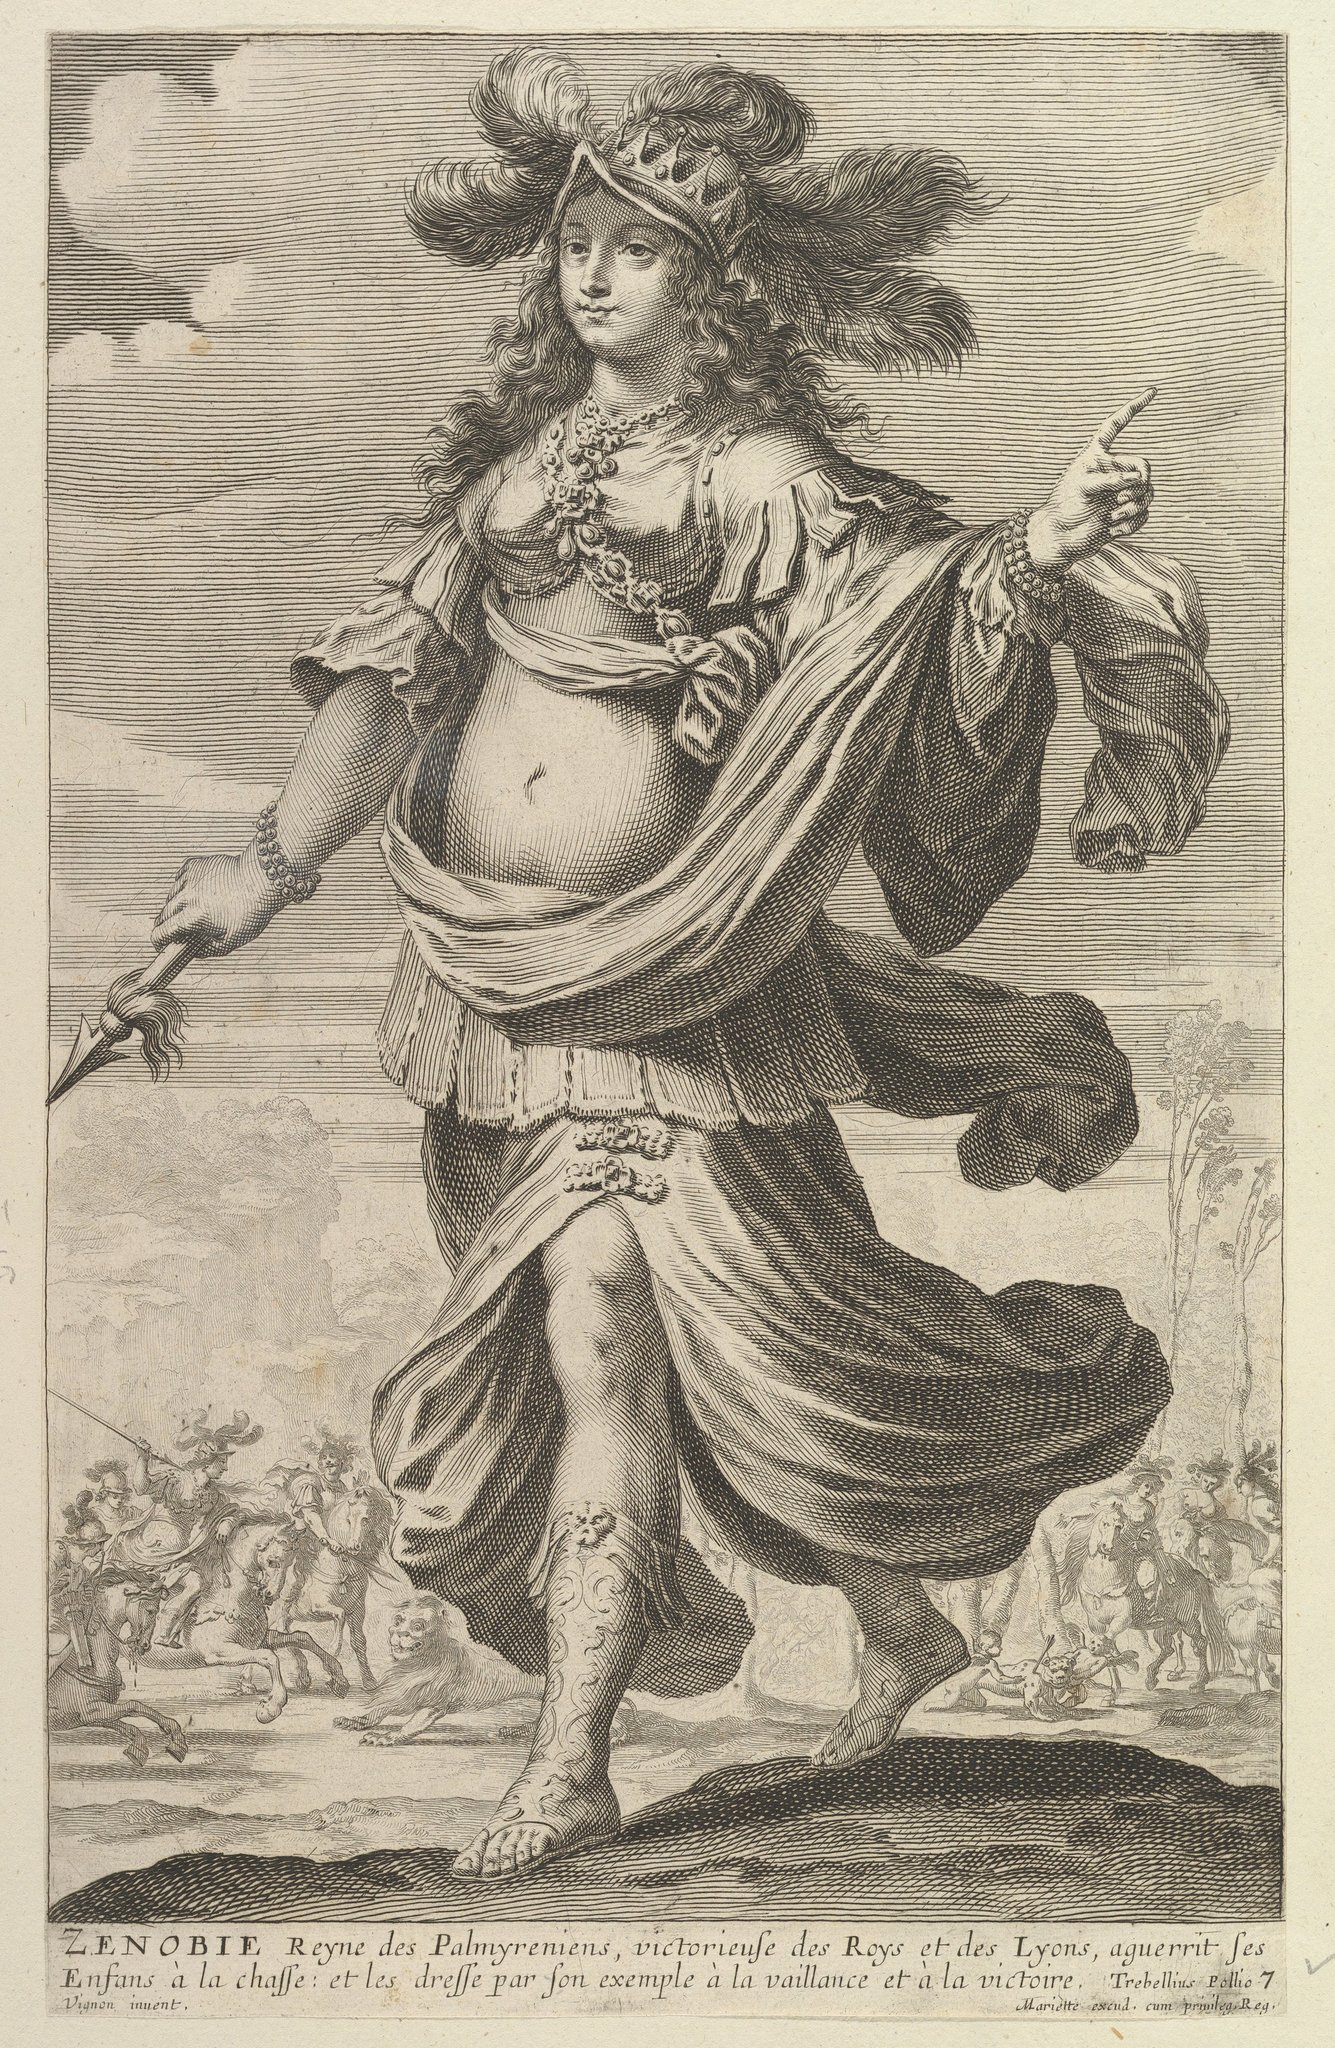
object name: print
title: Zénobie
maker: gilles rousselet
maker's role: artist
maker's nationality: french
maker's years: 1614-1686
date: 1647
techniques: engraving, etching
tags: queens